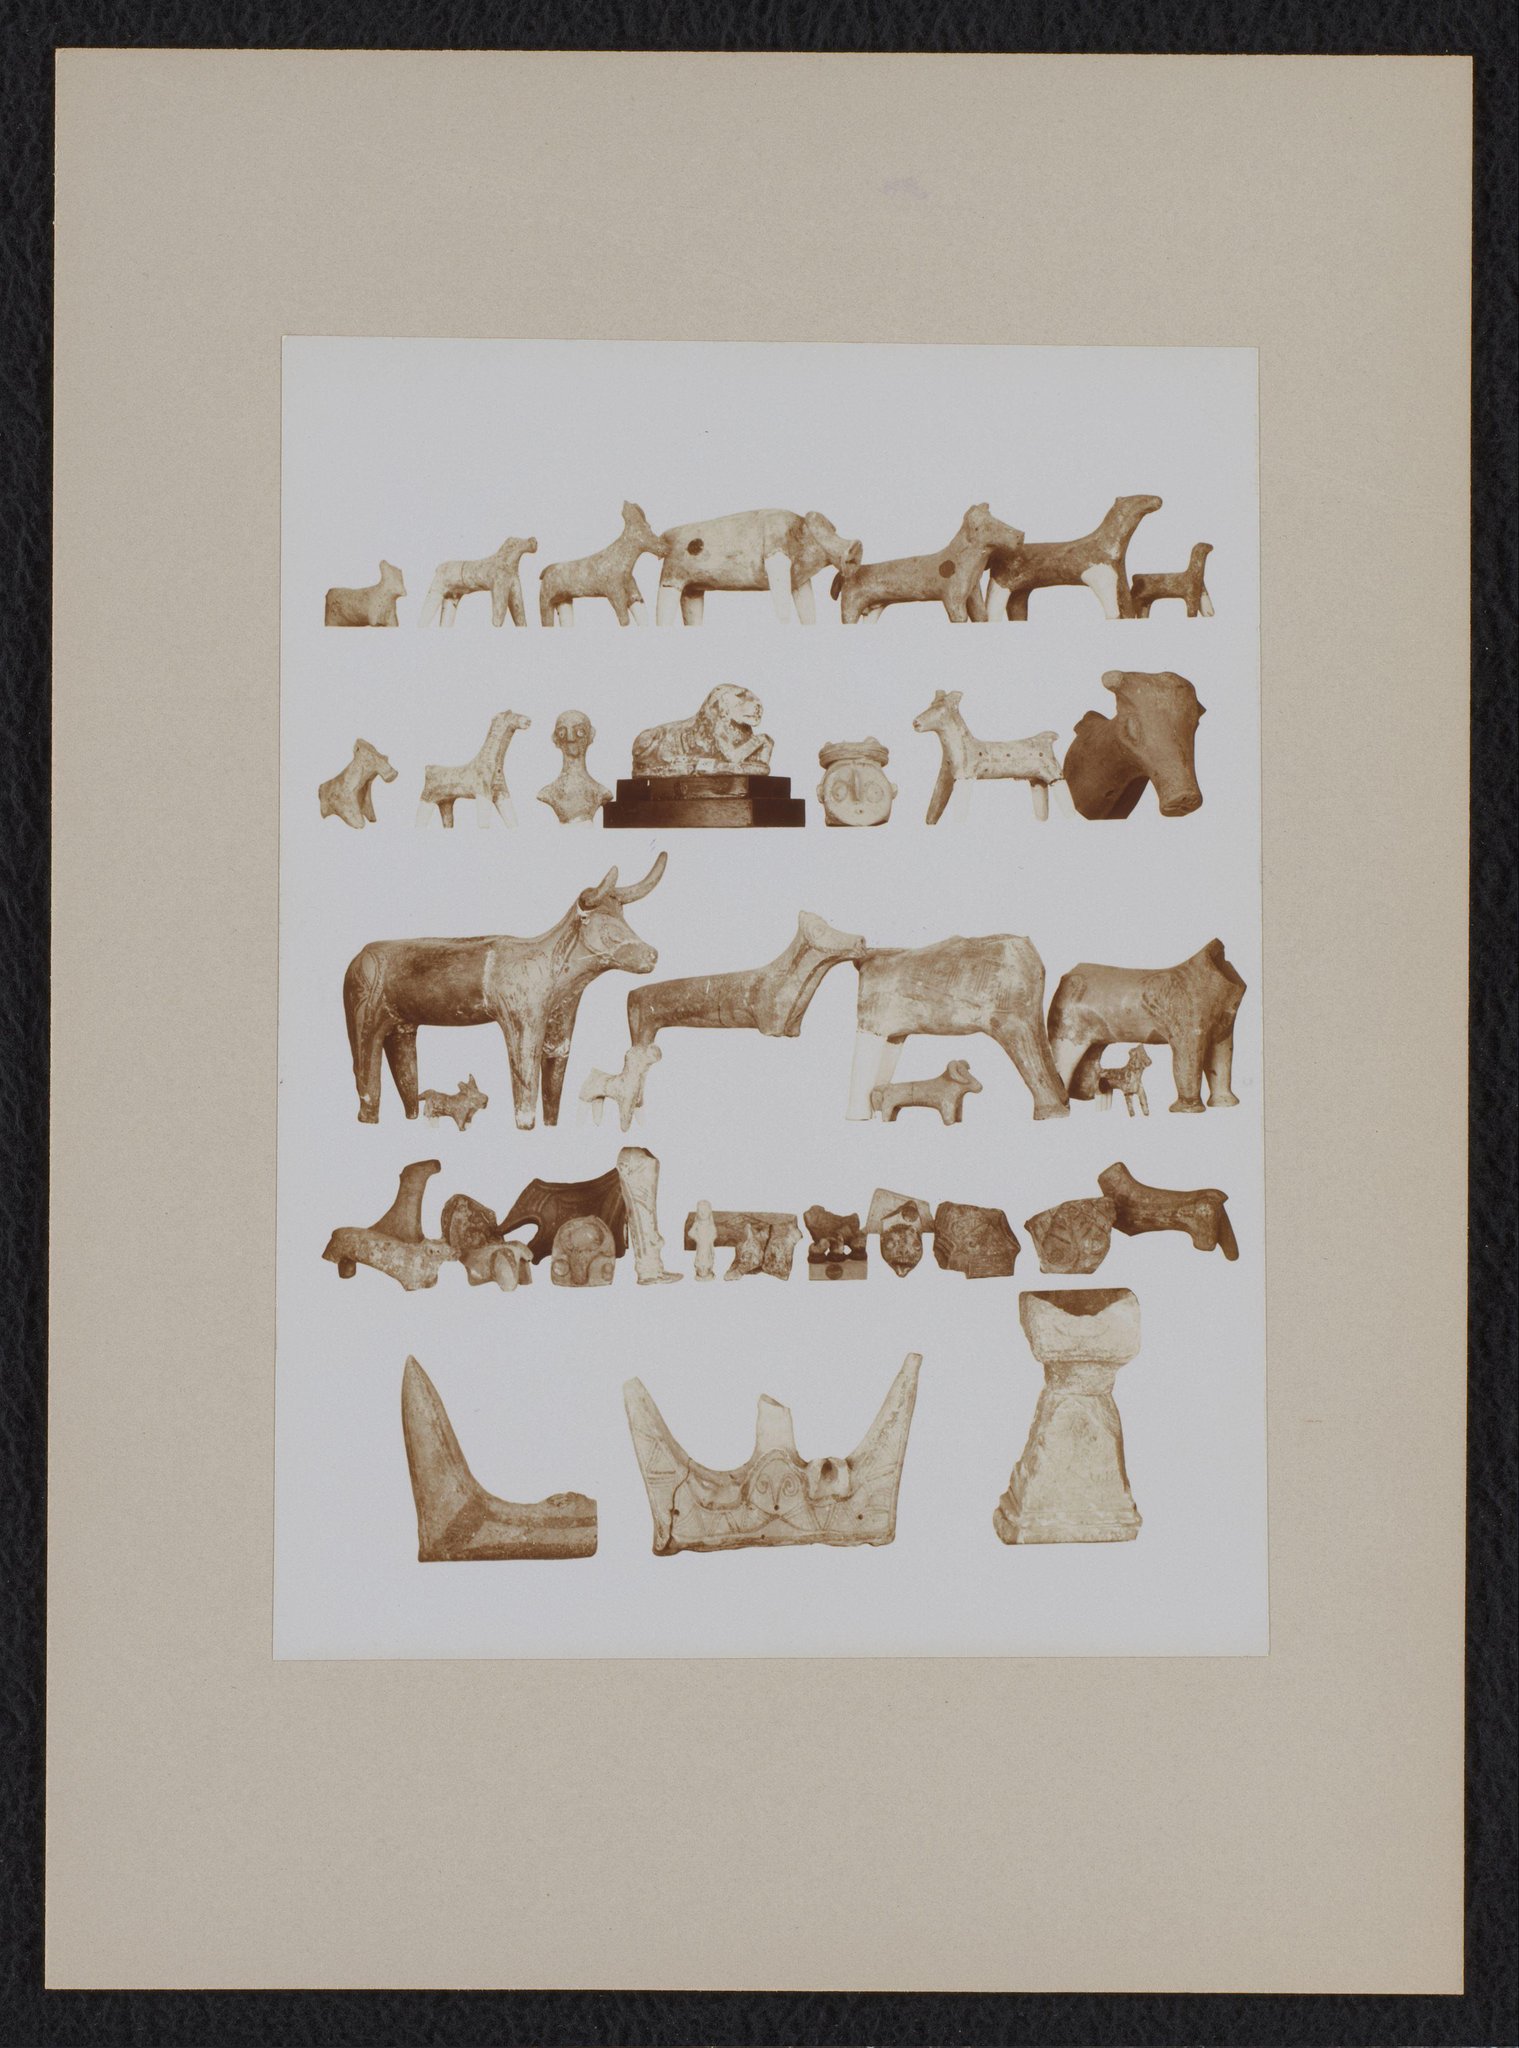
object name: photograph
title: Vijf rijen met objecten uit een museum op Kreta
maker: Anonymous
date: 1895-1915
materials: cardboard, paper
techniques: gelatin silver print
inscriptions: annotation: ‘59. Muzeum te Candia.’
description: Bovenaan bevindt zich een rij met zeven dieren.